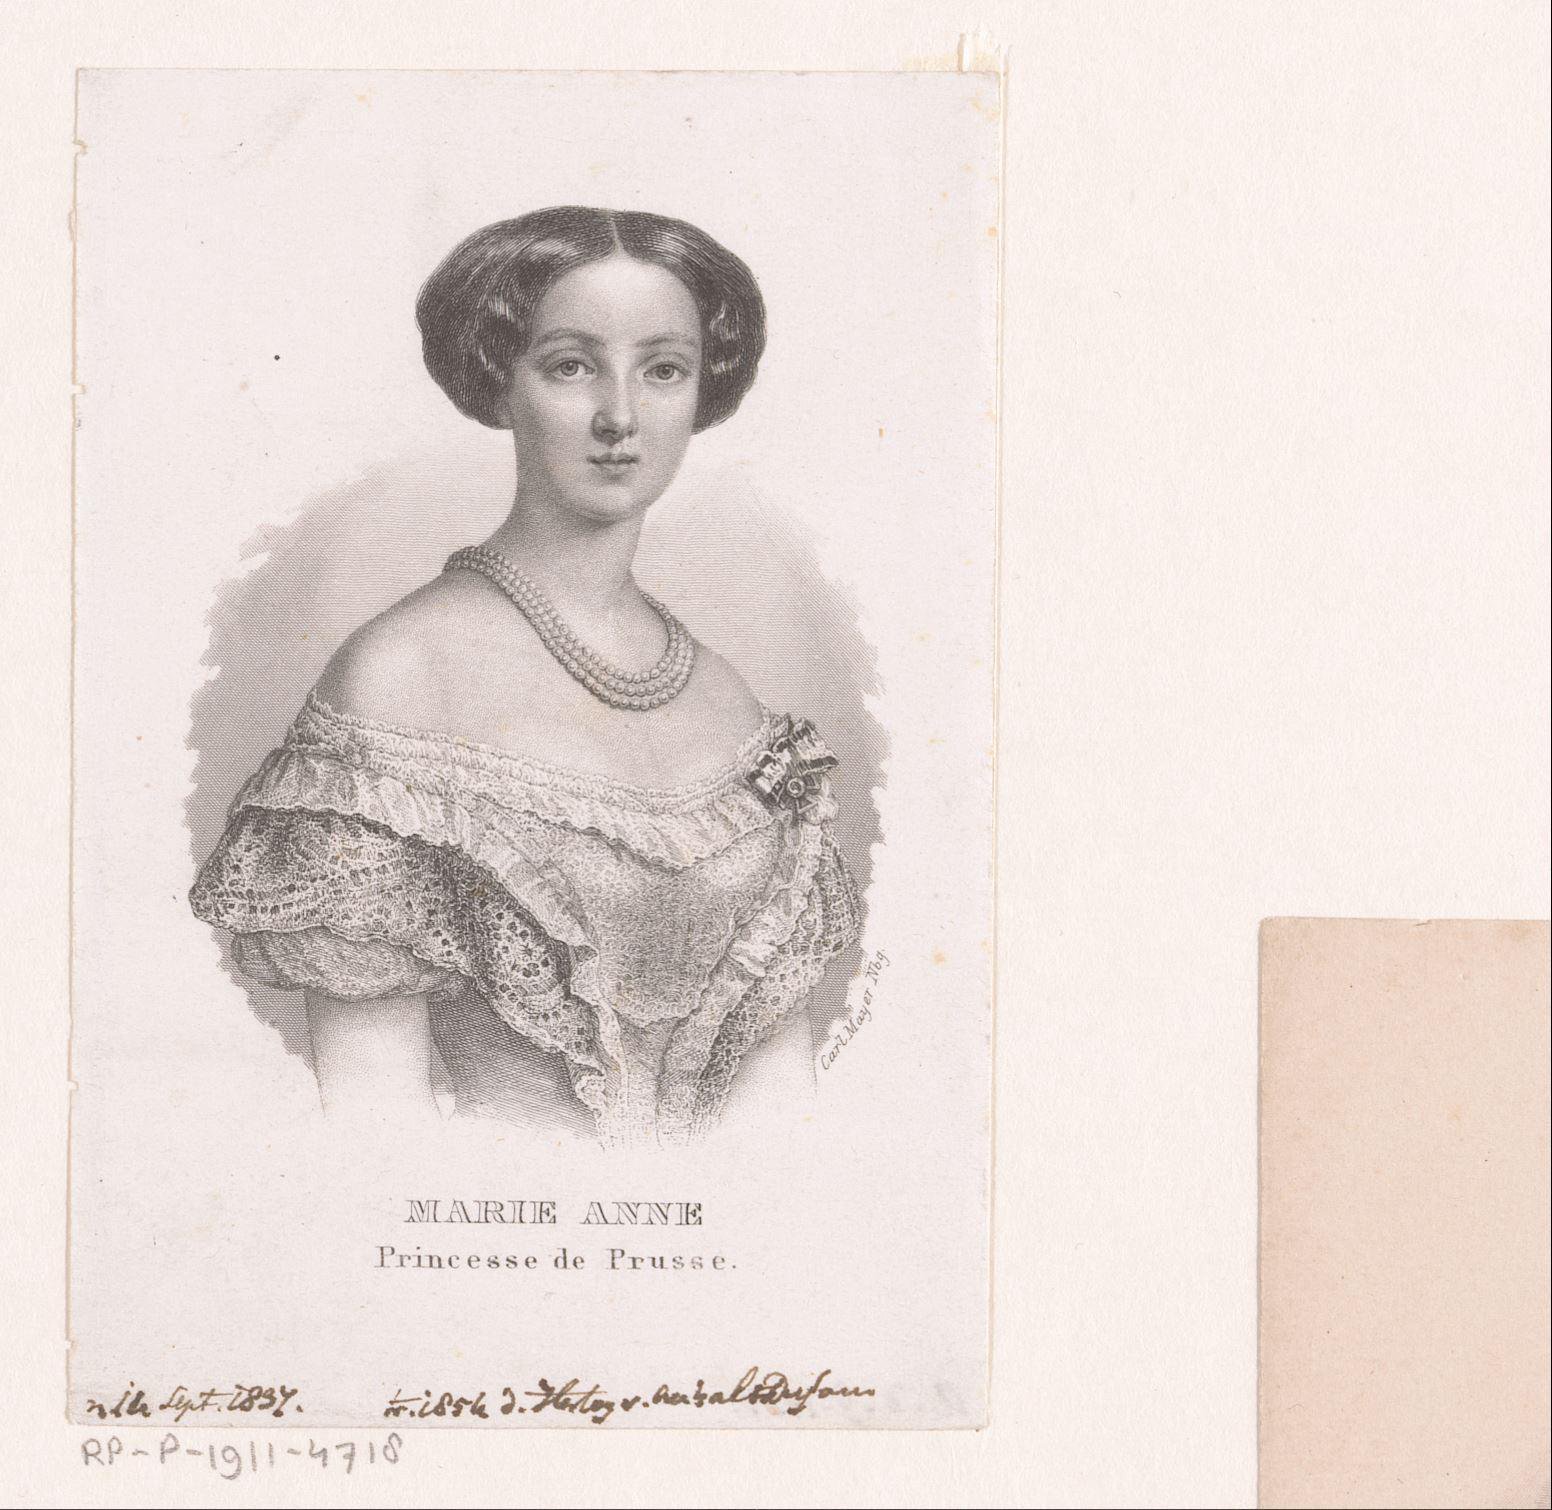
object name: print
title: Portret van Maria Anna van Pruisen, geboren prinses van Anhalt-Dessau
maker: carl mayer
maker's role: print maker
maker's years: 1798-1868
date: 1837-1868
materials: paper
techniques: engraving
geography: nuremberg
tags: historical persons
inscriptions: collector's mark: Lugt 2228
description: Prent mogelijk afkomstig uit de Almanach de Gotha.